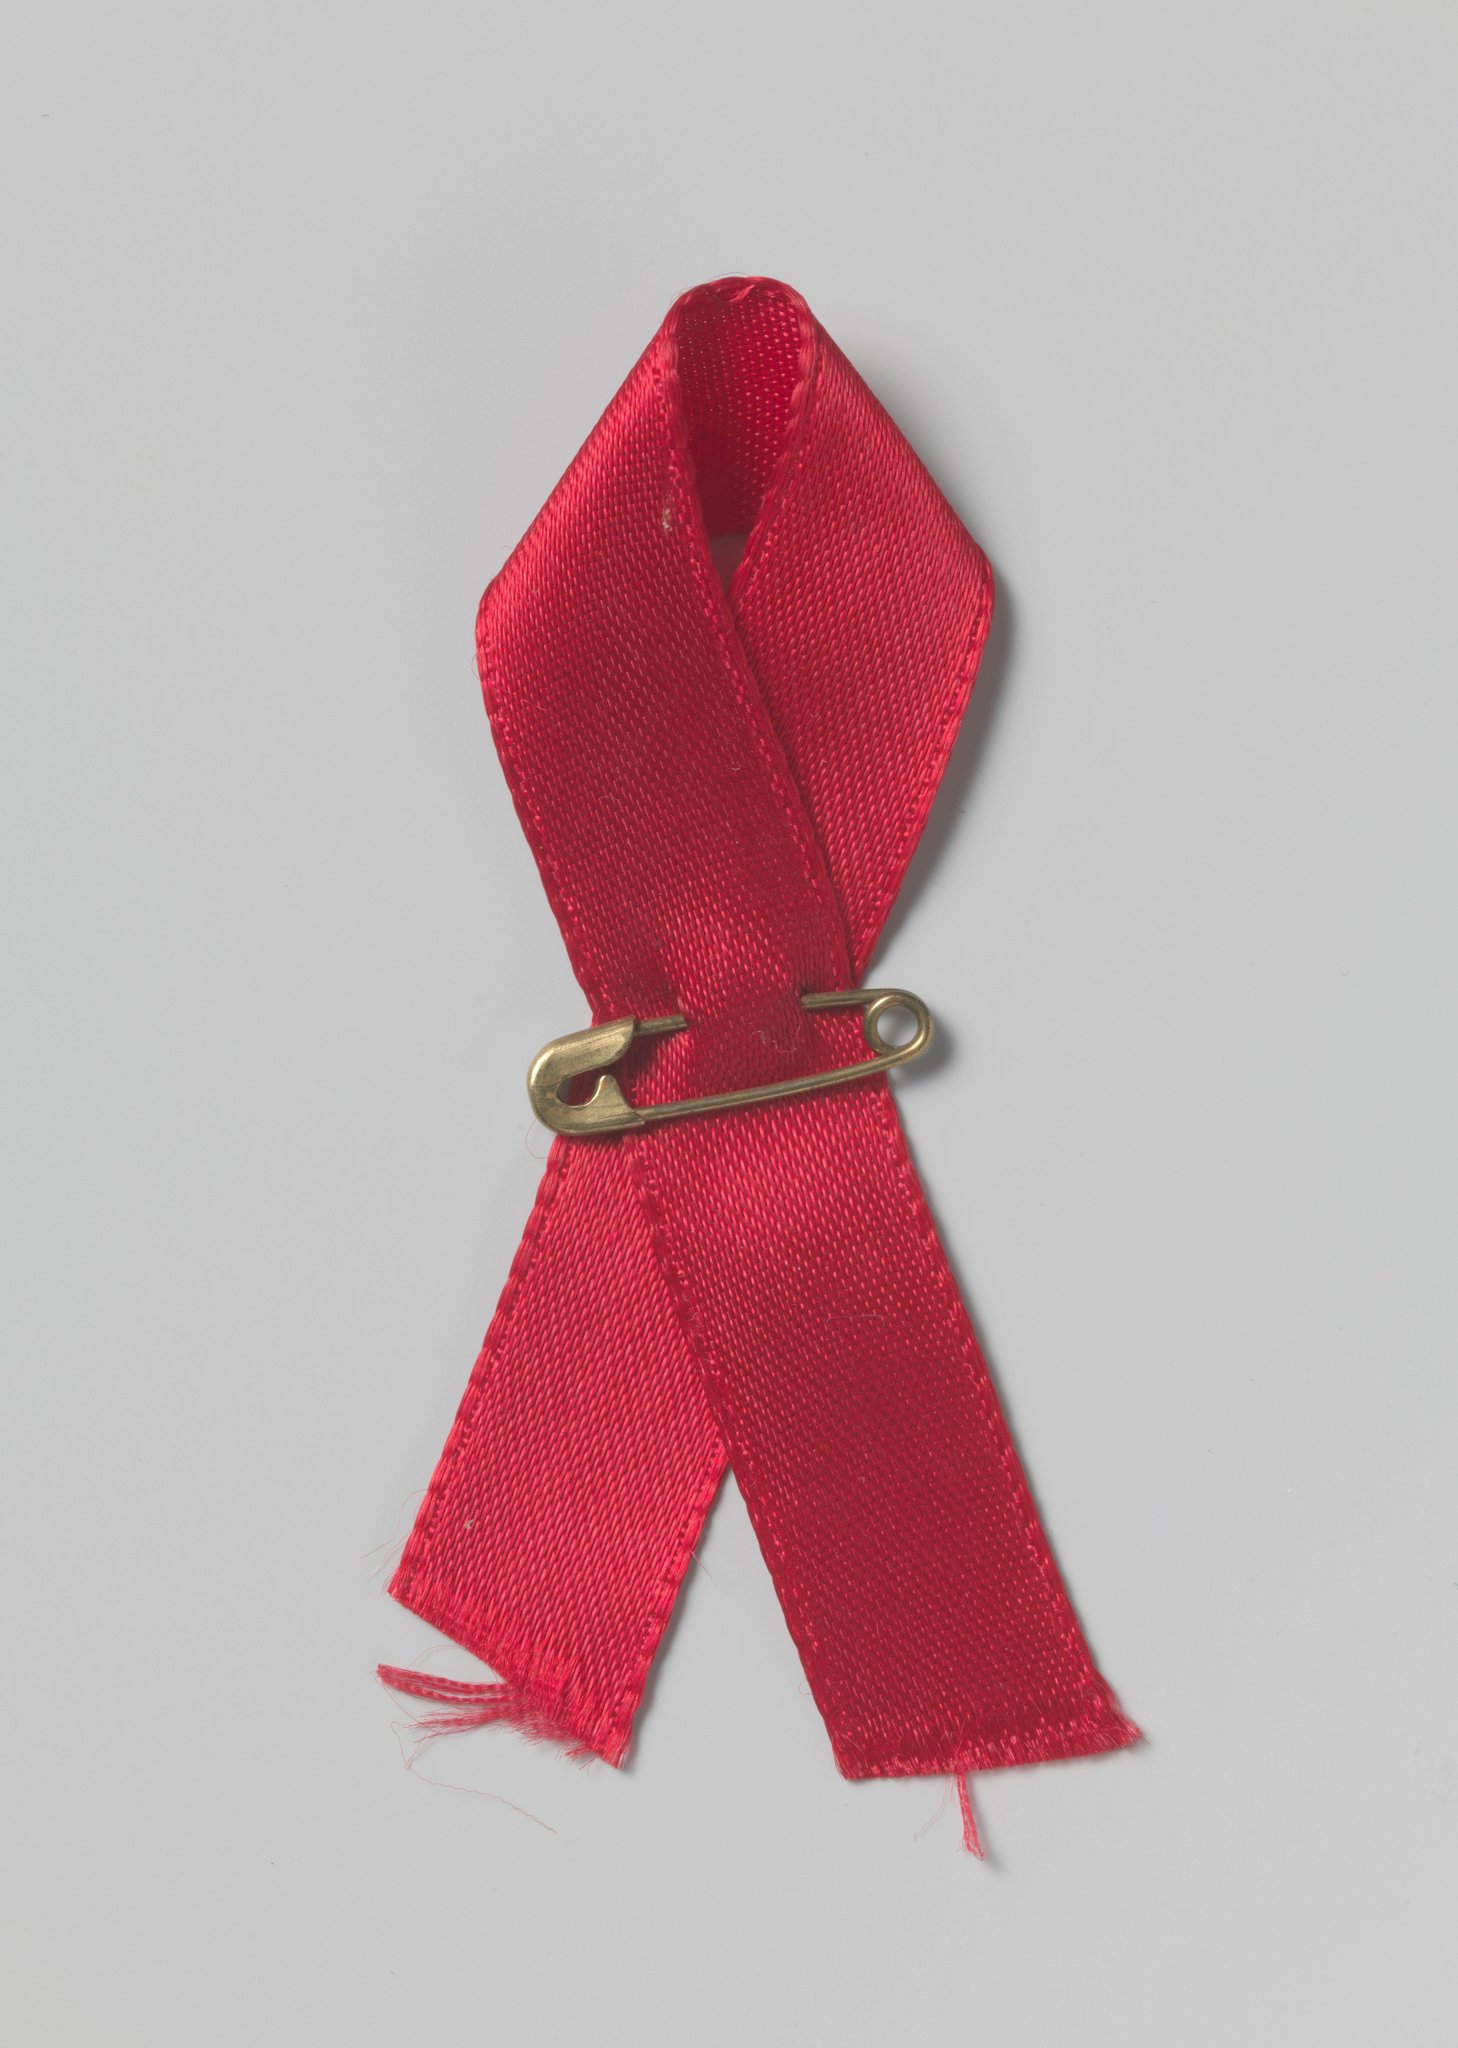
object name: ribbon material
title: Red Ribbon met veiligheidsspeld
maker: Anonymous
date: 1985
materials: metal, ribbon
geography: san francisco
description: Red Ribbon met veiligheidsspeld. Een rode lus die door middel van een veiligheidsspeld op kleding kan worden aangebracht.